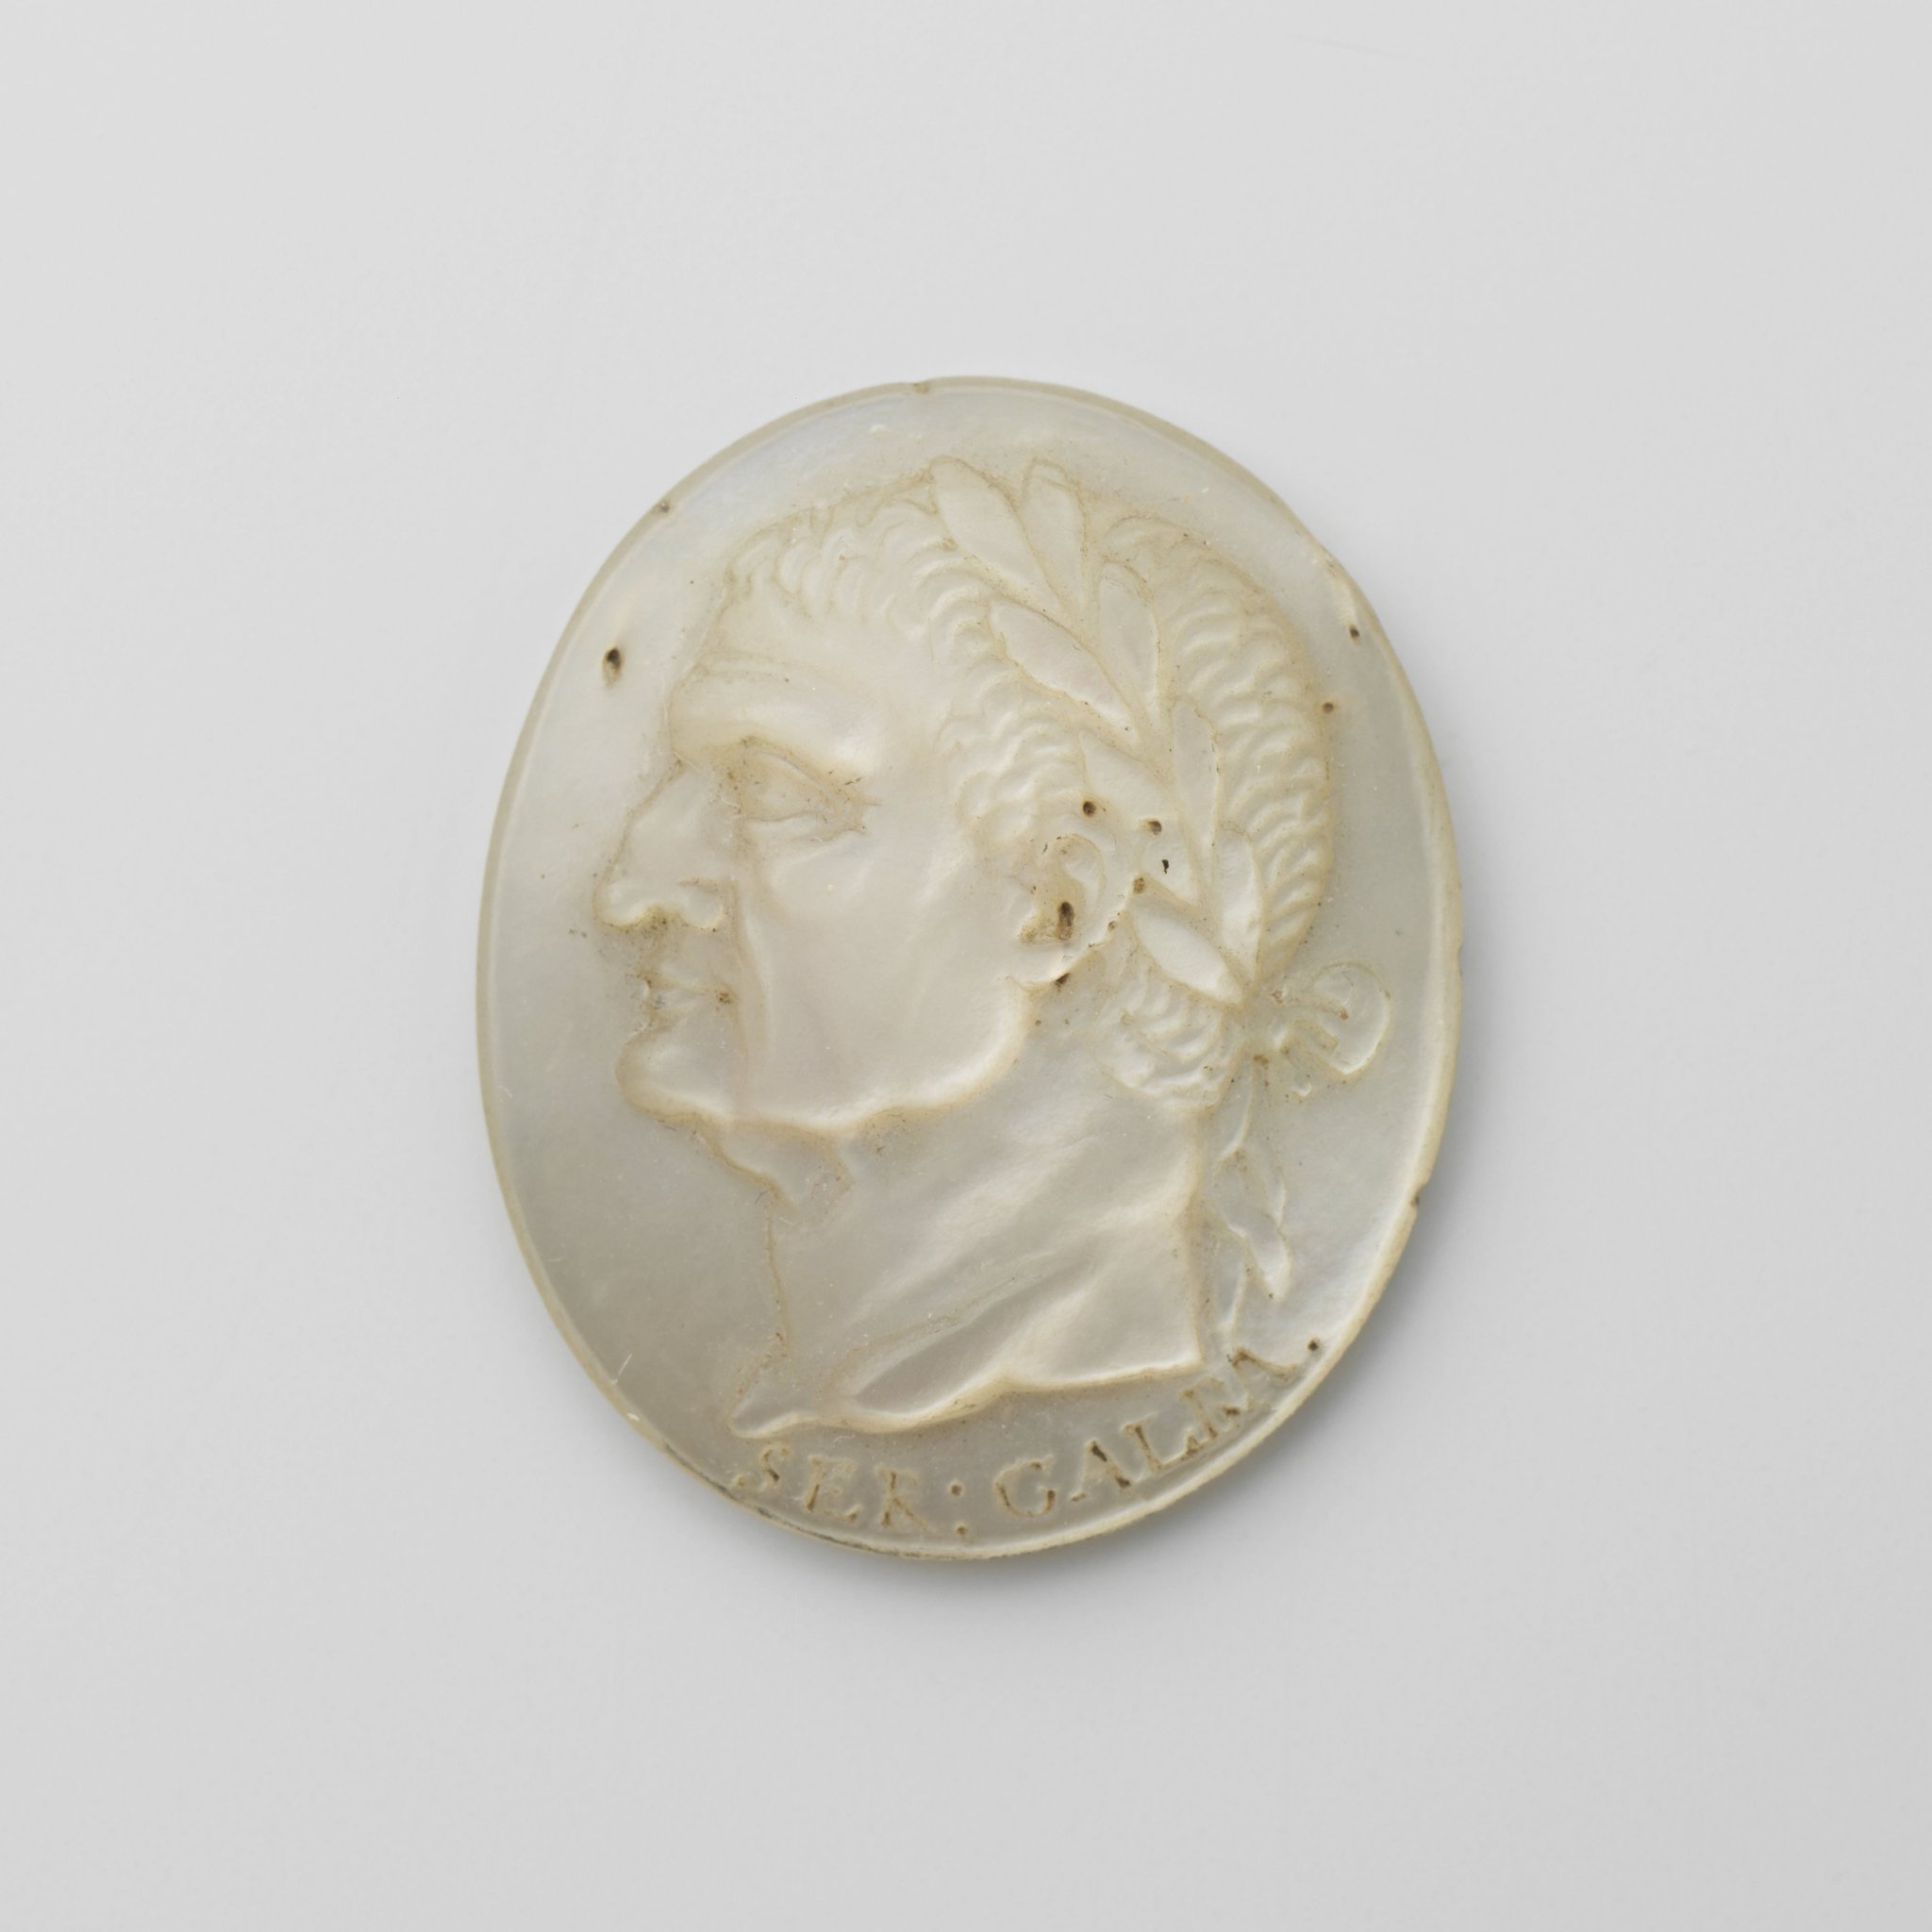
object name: locket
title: Servius Sulpicius Galba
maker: Anonymous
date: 1700-1800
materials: mother of pearl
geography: netherlands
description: Een medaillon van parelmoer, waarop een afbeelding is gesneden van een Romeinse keizer, met randschrift: SER:GALBA.